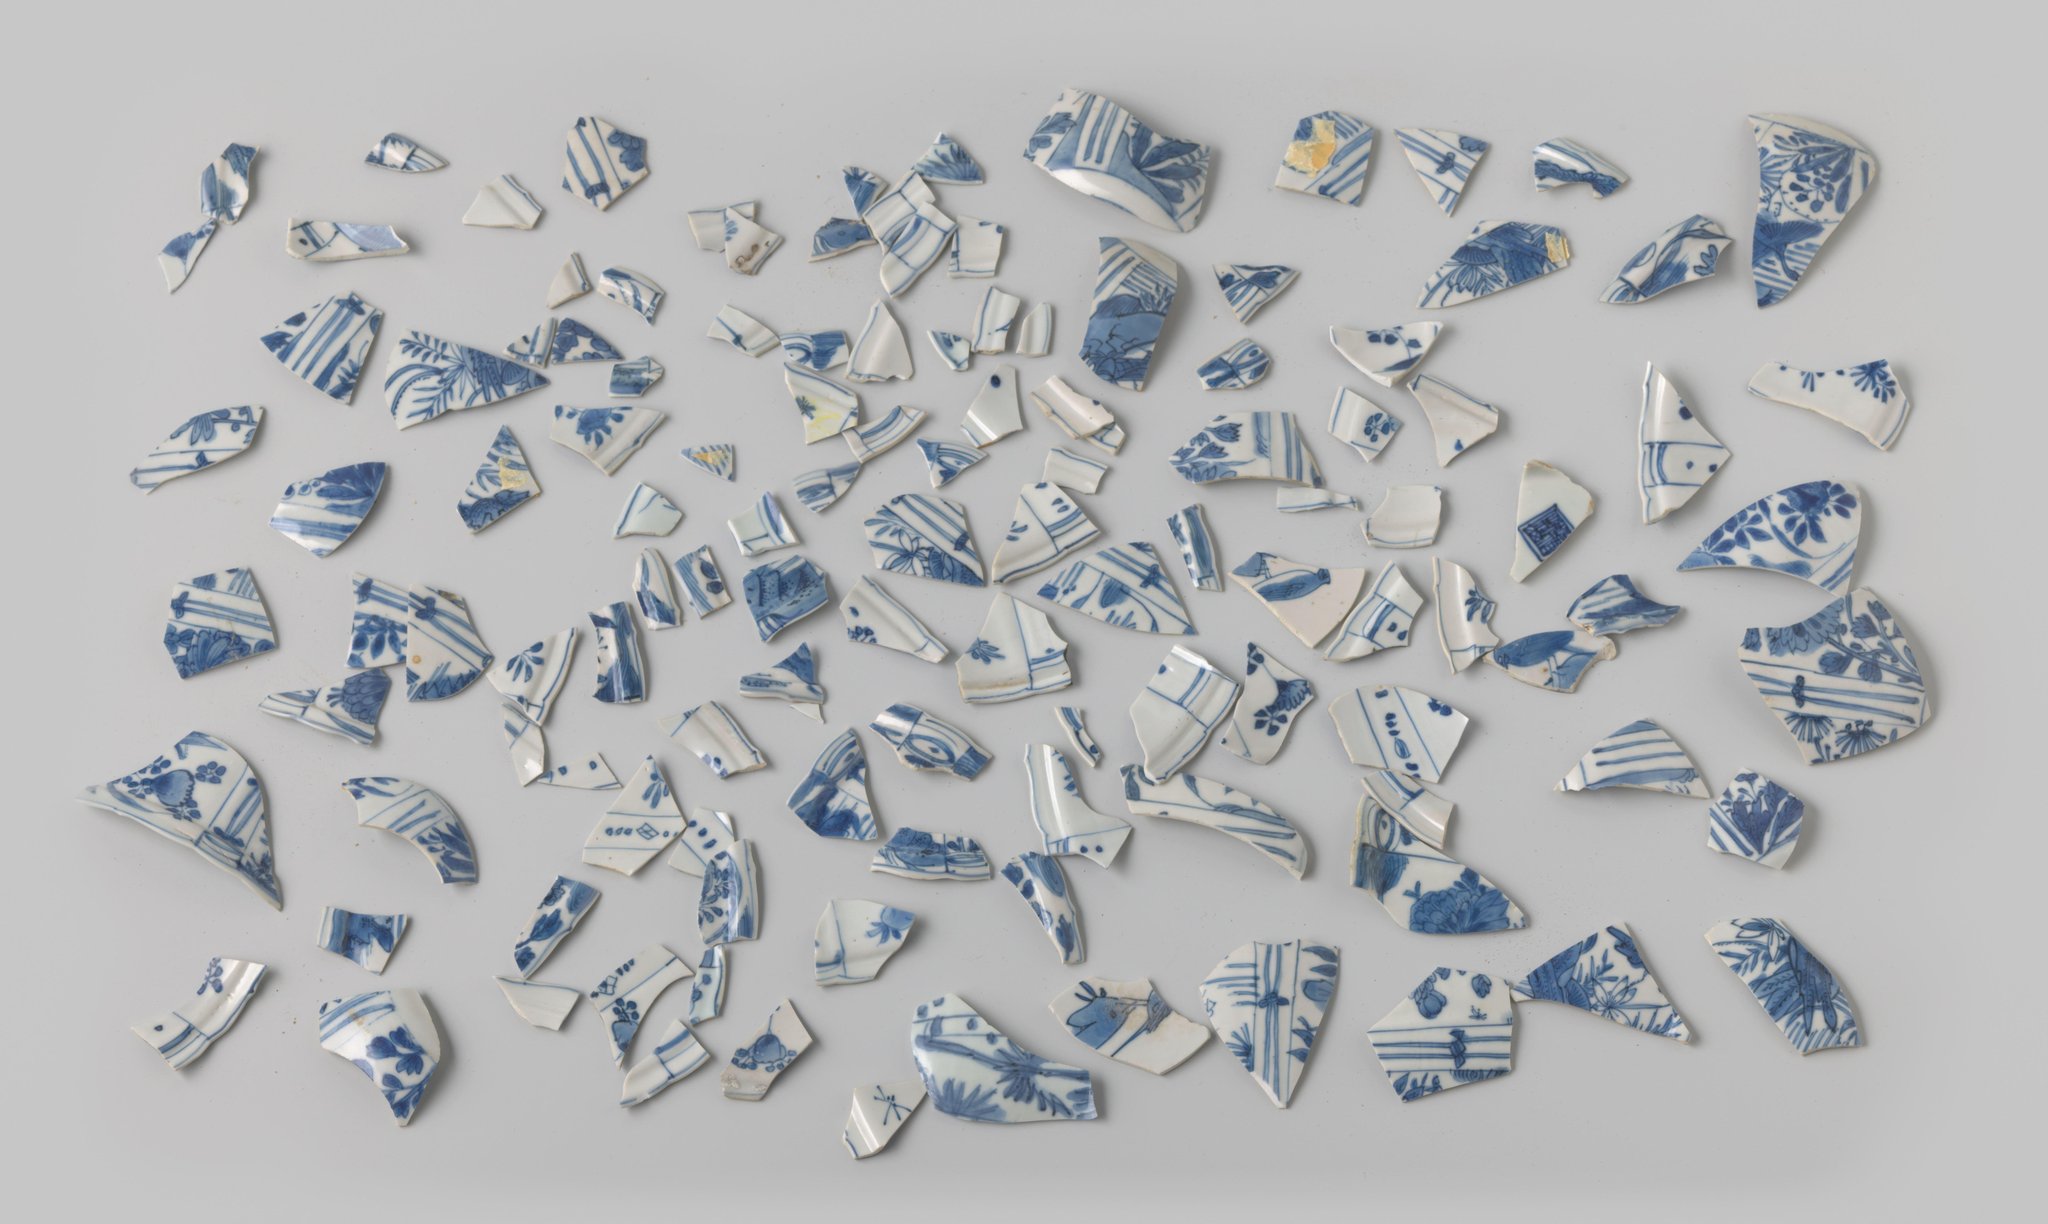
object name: kraaikop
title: Scherven van kraaikoppen uit V.O.C.-schip de 'Witte Leeuw'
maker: Anonymous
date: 1613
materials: bone china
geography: jingdezhen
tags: verenigde oostindische compagnie, sint-helena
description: A high bowl. The inside decorated with flower- and fruit-sprays. The exterior with flowers, a cicada and birds.